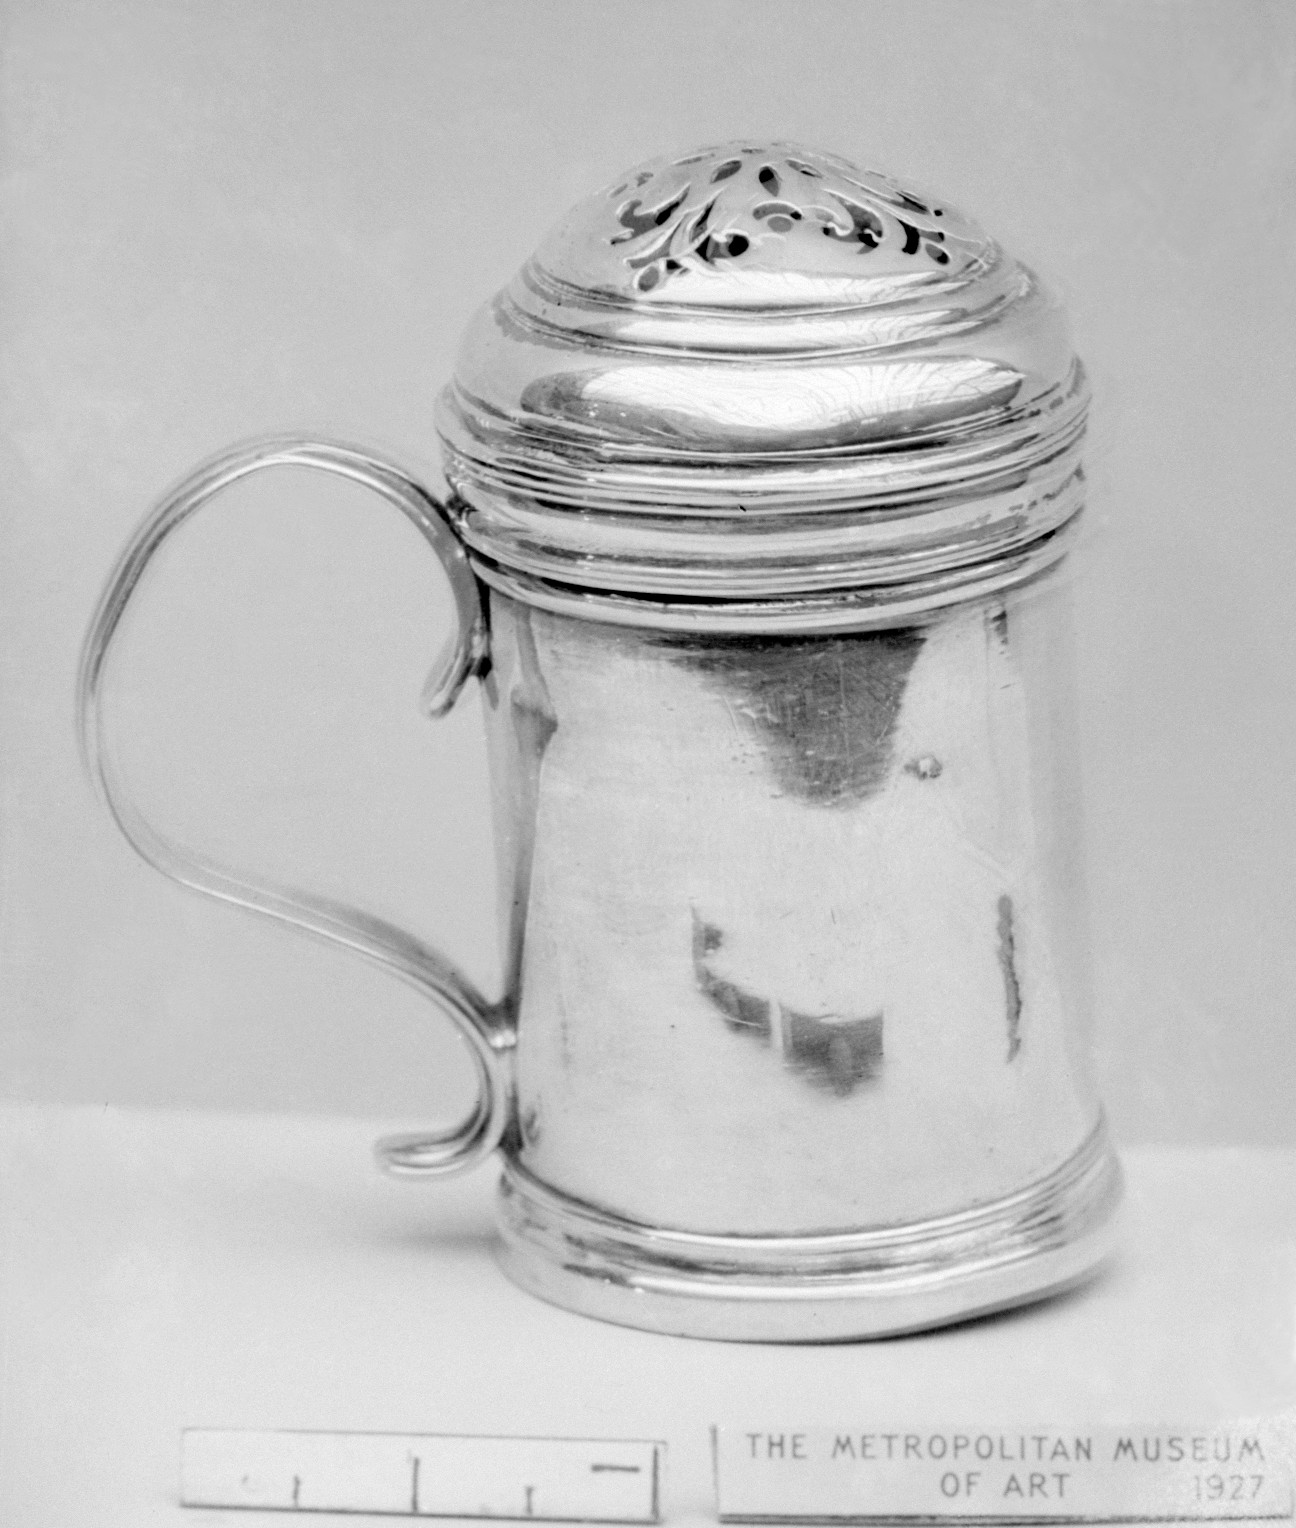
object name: caster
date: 1720-1750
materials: silver